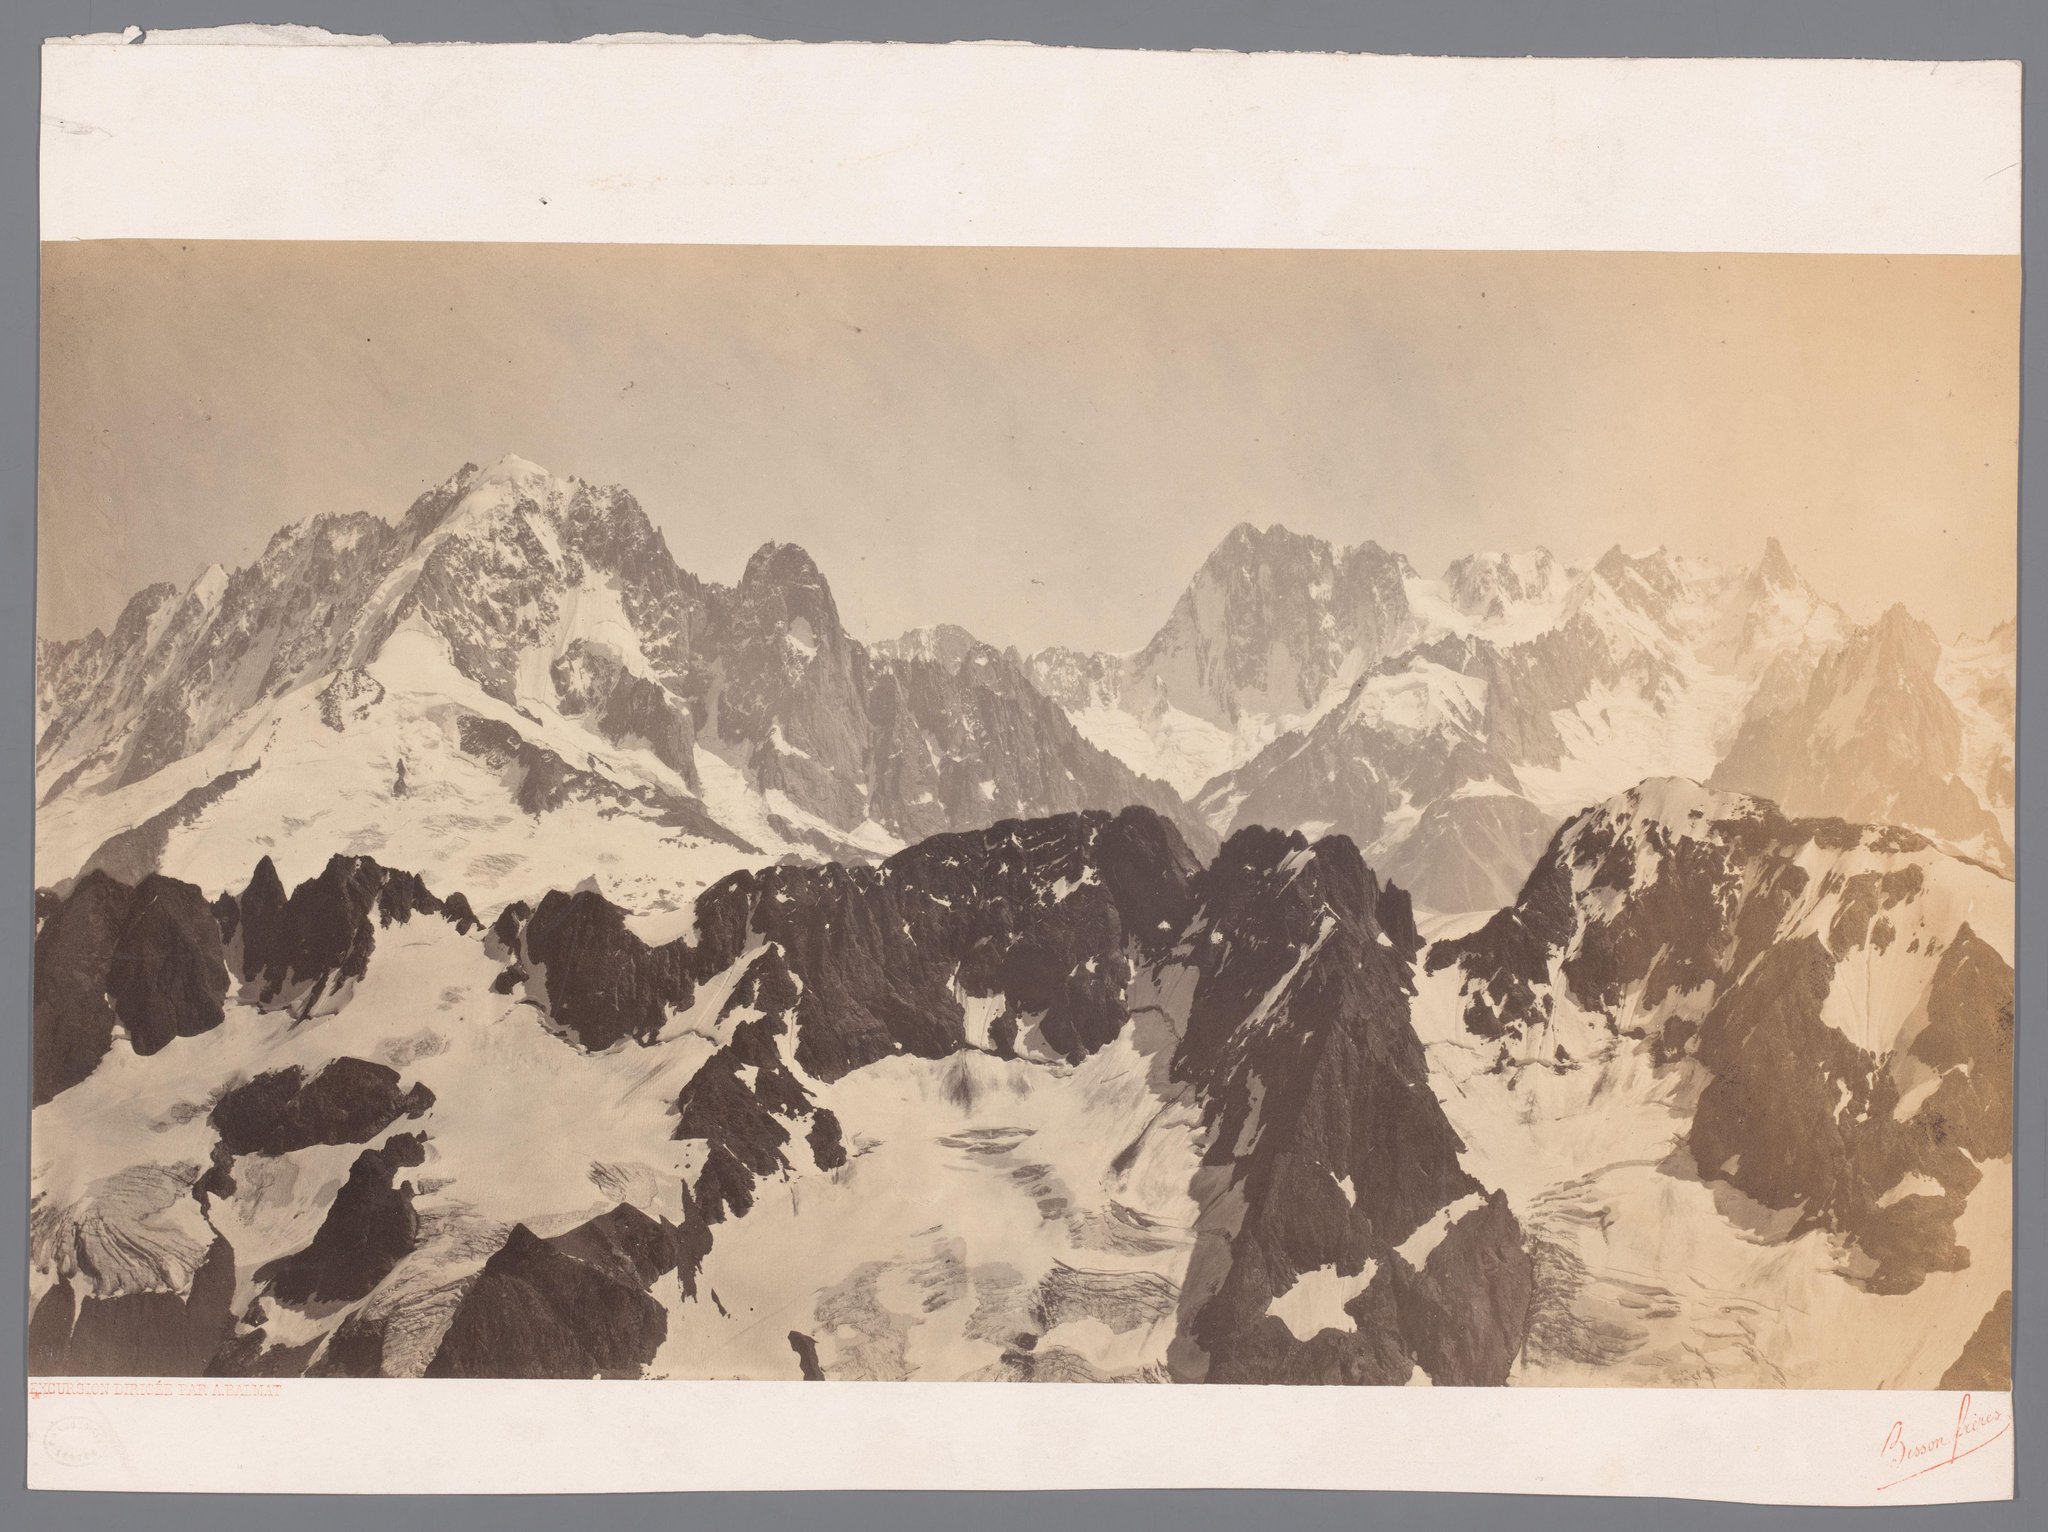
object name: photograph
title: Berggezicht/Mont Blanc/Alpen [?]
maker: t.h. cladwell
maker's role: publisher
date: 1860-1880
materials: cardboard, paper, photographic support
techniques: albumen print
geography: france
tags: alpen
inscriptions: check stamp: ‘T.H. Cladwell//London’, check stamp: ‘FBF’, caption: ‘EXCURSIONS DIRICÉE PAR A. BALMAT’, stamp: ‘Bisson frères’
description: Berggezicht vanuit een hoog standpunt/berg.